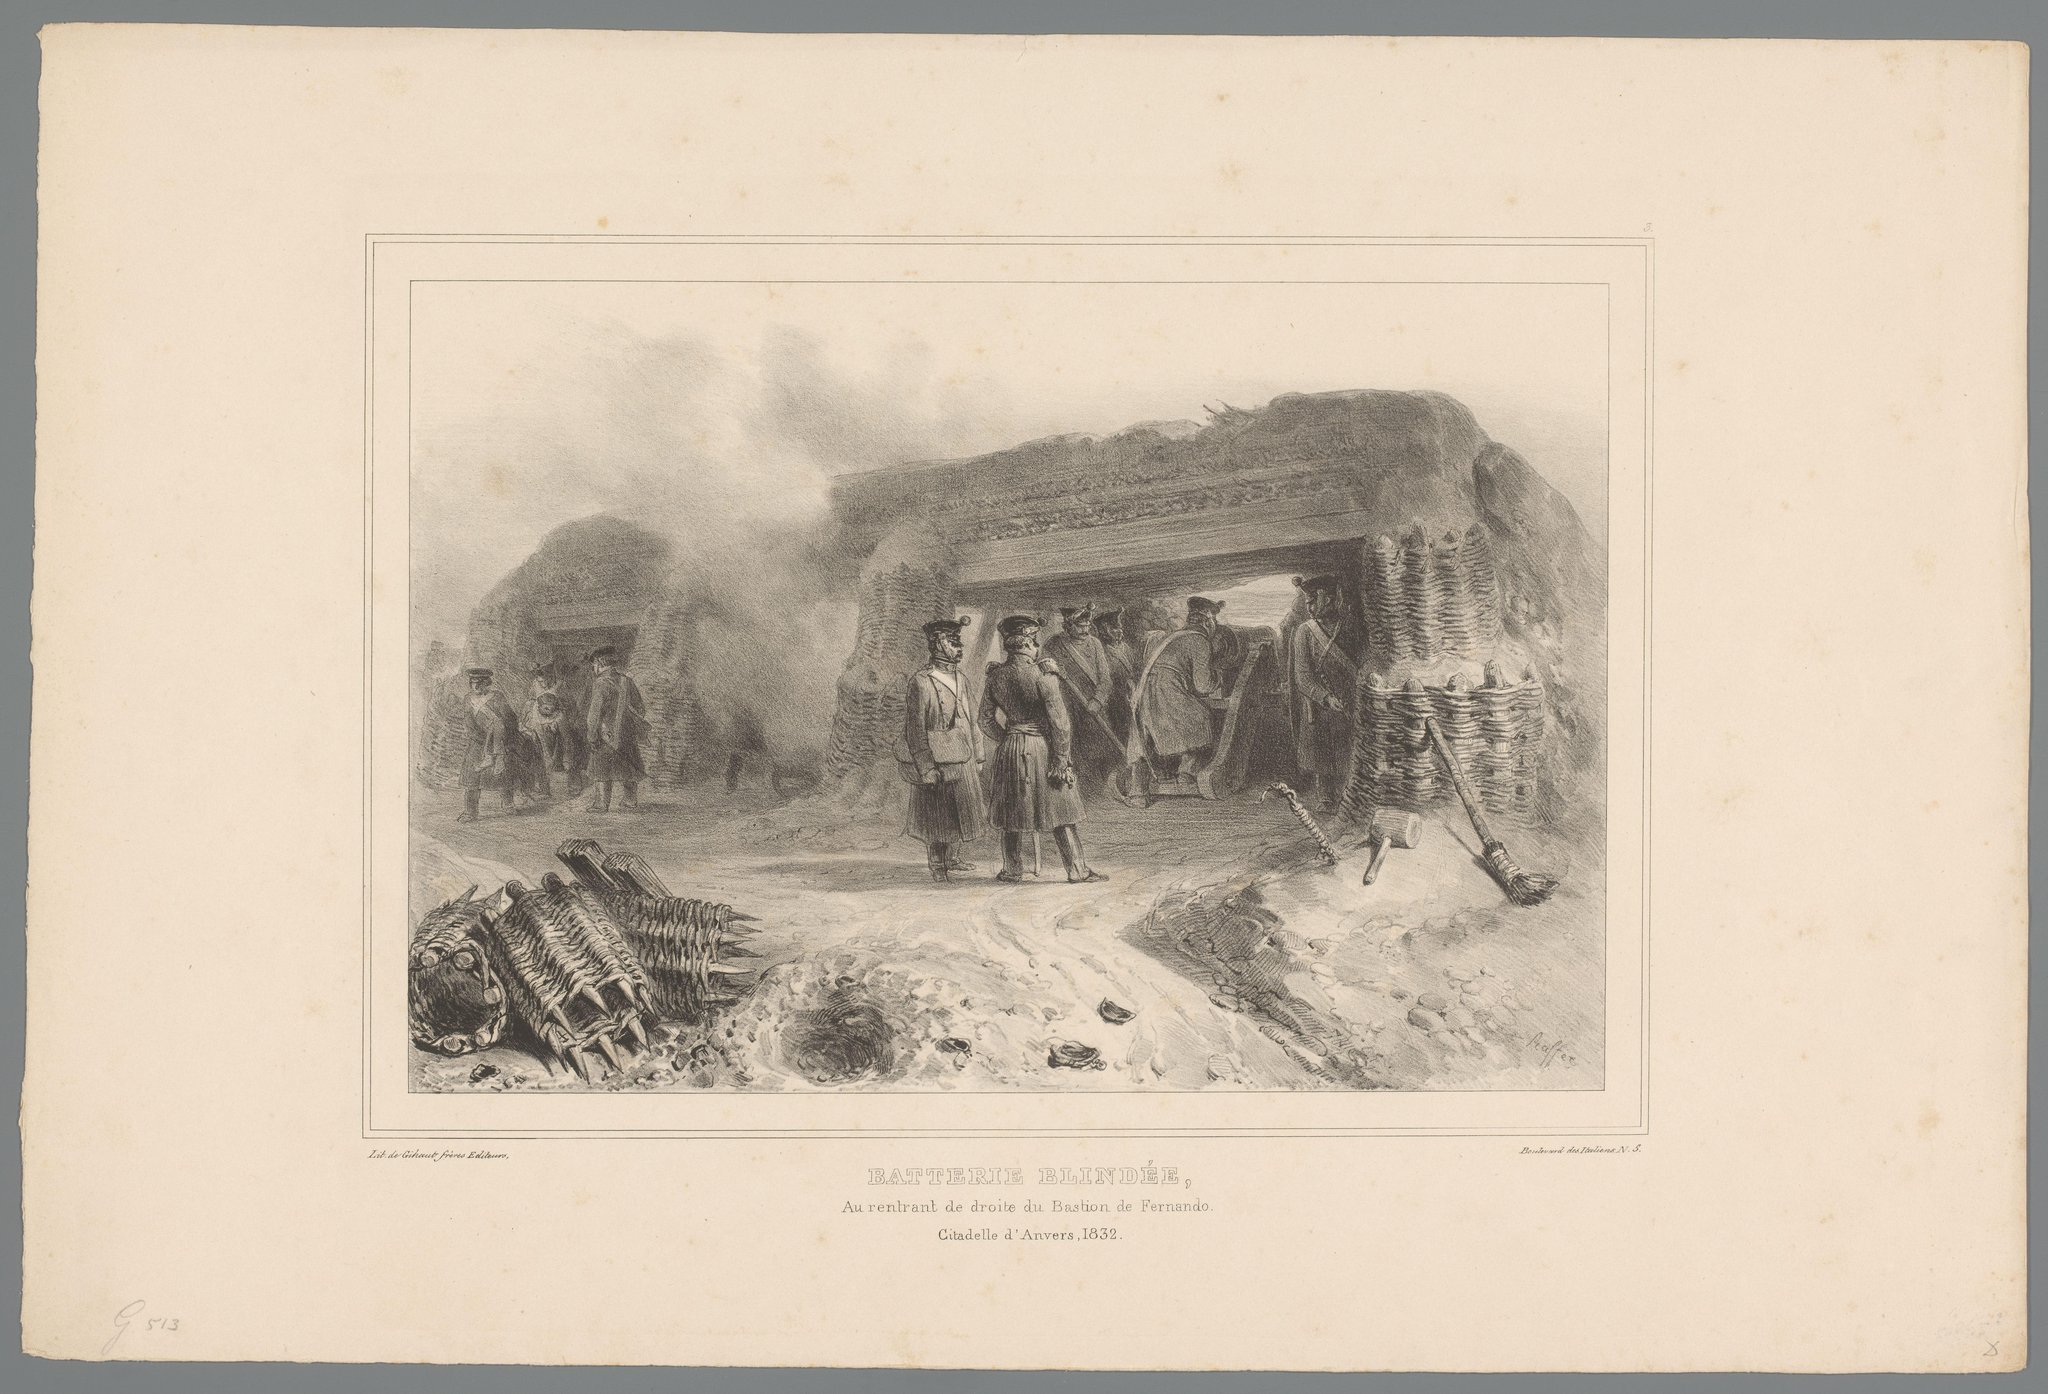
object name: print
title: Beleg van de Citadel van Antwerpen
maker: denis auguste marie raffet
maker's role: draughtsman, print maker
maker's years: 1804-1860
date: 1833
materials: paper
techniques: lithograph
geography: paris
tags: siege, position war, firearms: cannon, the soldier; the soldier's life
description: Militairen bij een ingegraven kanon; op de linkervoorgrond enkele korven. Links achter wordt een gewonde weggedragen. Onderdeel van de serie van 24 prenten over het beleg van de Citadel van Antwerpen, 30 november - 23 december 1832.